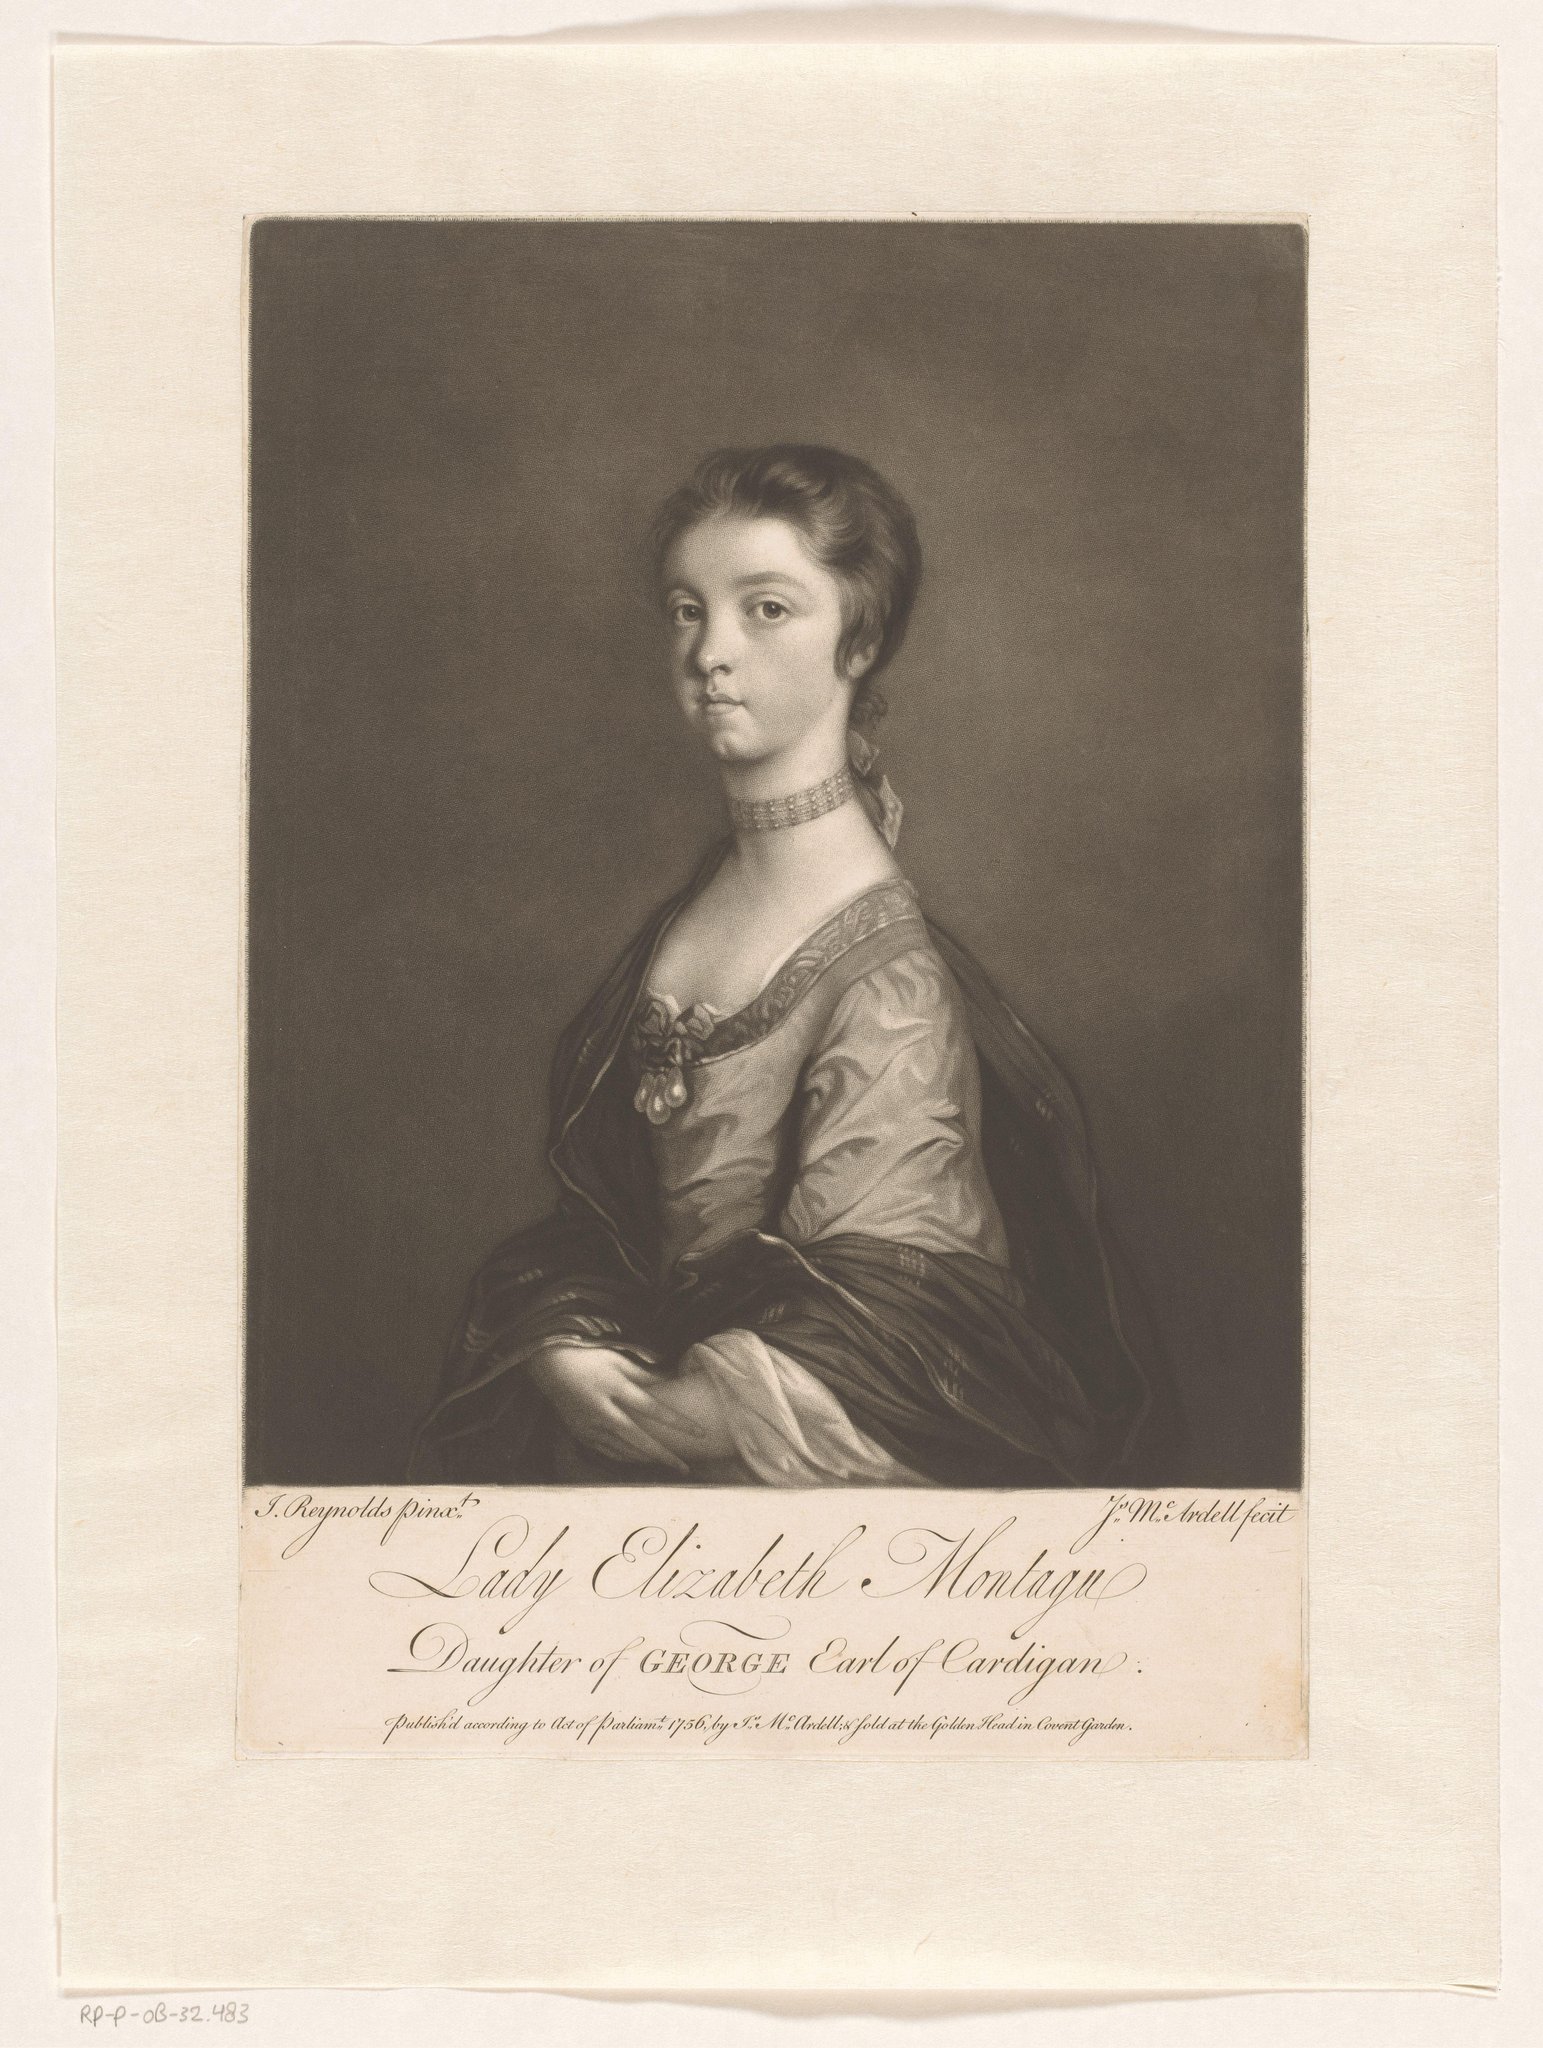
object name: print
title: Lady Elizabeth Montagu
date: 1756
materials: paper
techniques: mezzotint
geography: london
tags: historical persons - bb - woman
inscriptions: collector's mark: Lugt 240